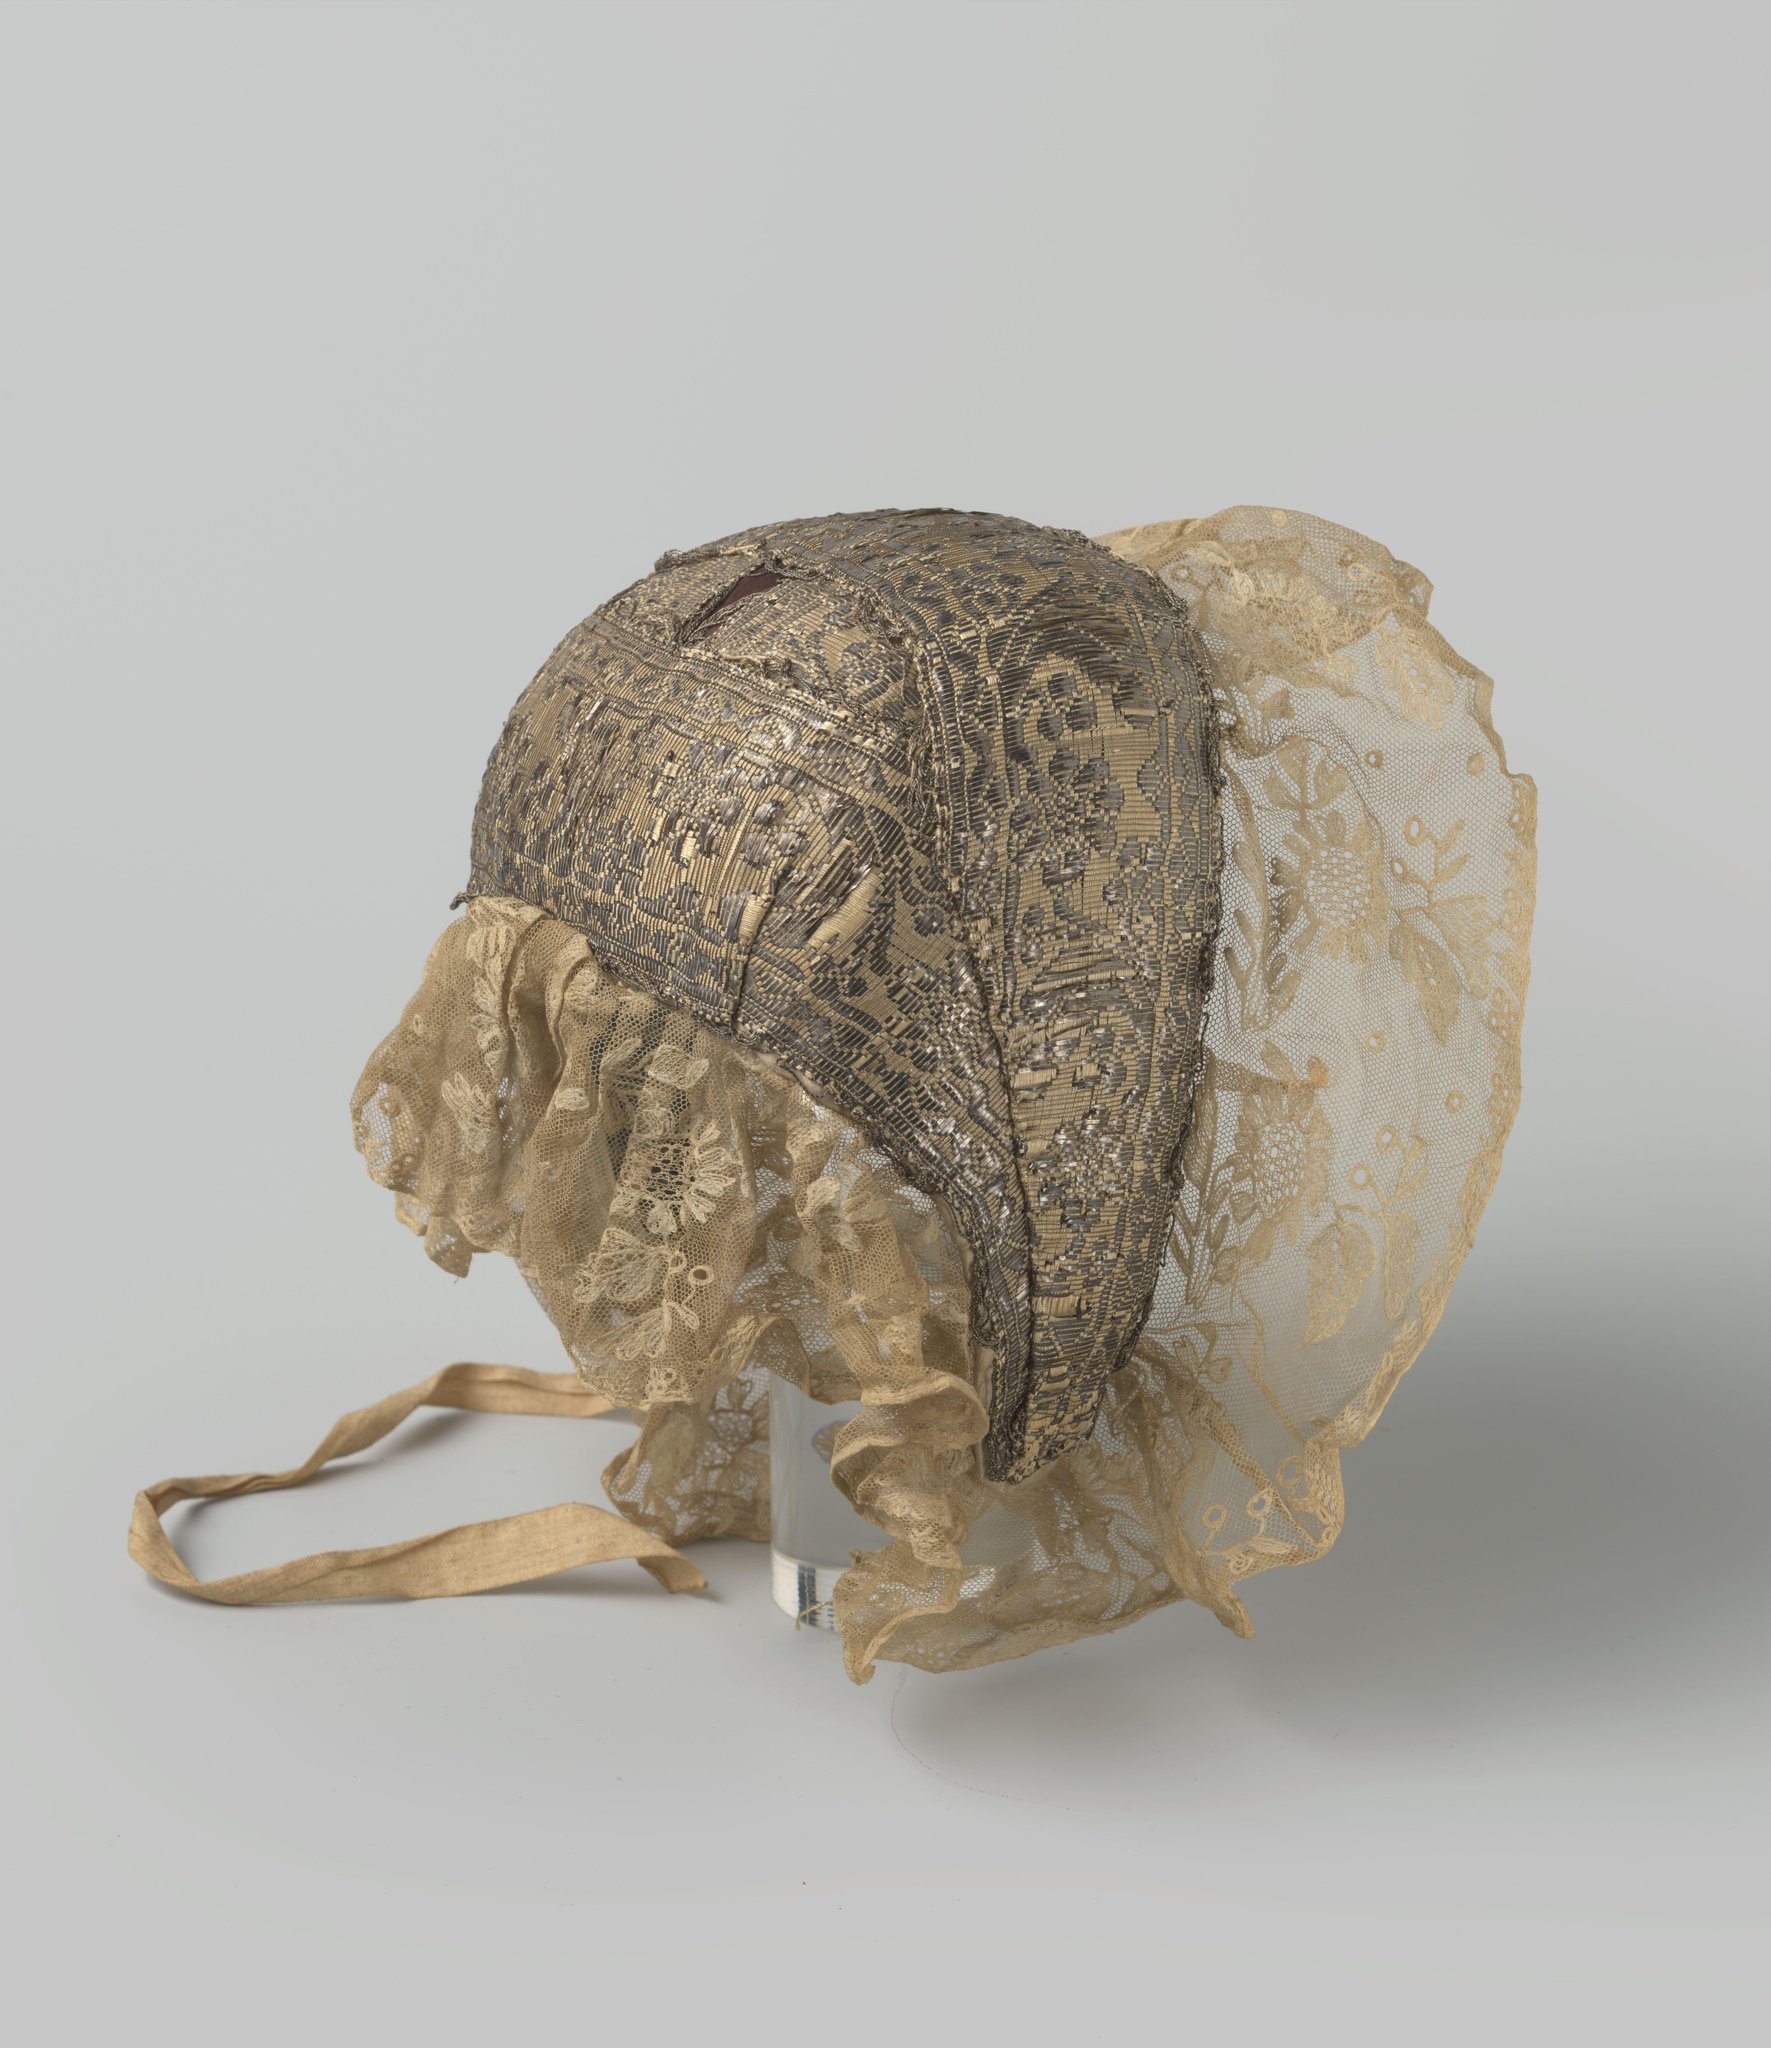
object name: childrenswear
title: Kinderhoed van bruine zijde met breed zilverpassement afgezet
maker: Anonymous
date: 1800-1825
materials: silk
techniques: embroidered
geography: france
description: Kinderhoed van bruine zijde versierd met breed zilverpassement en afgezet met kant. Stijf binnenwerk van gaas. Voering in grijs en blauw, gestreept linnen kantstrook met tule-doorstop.